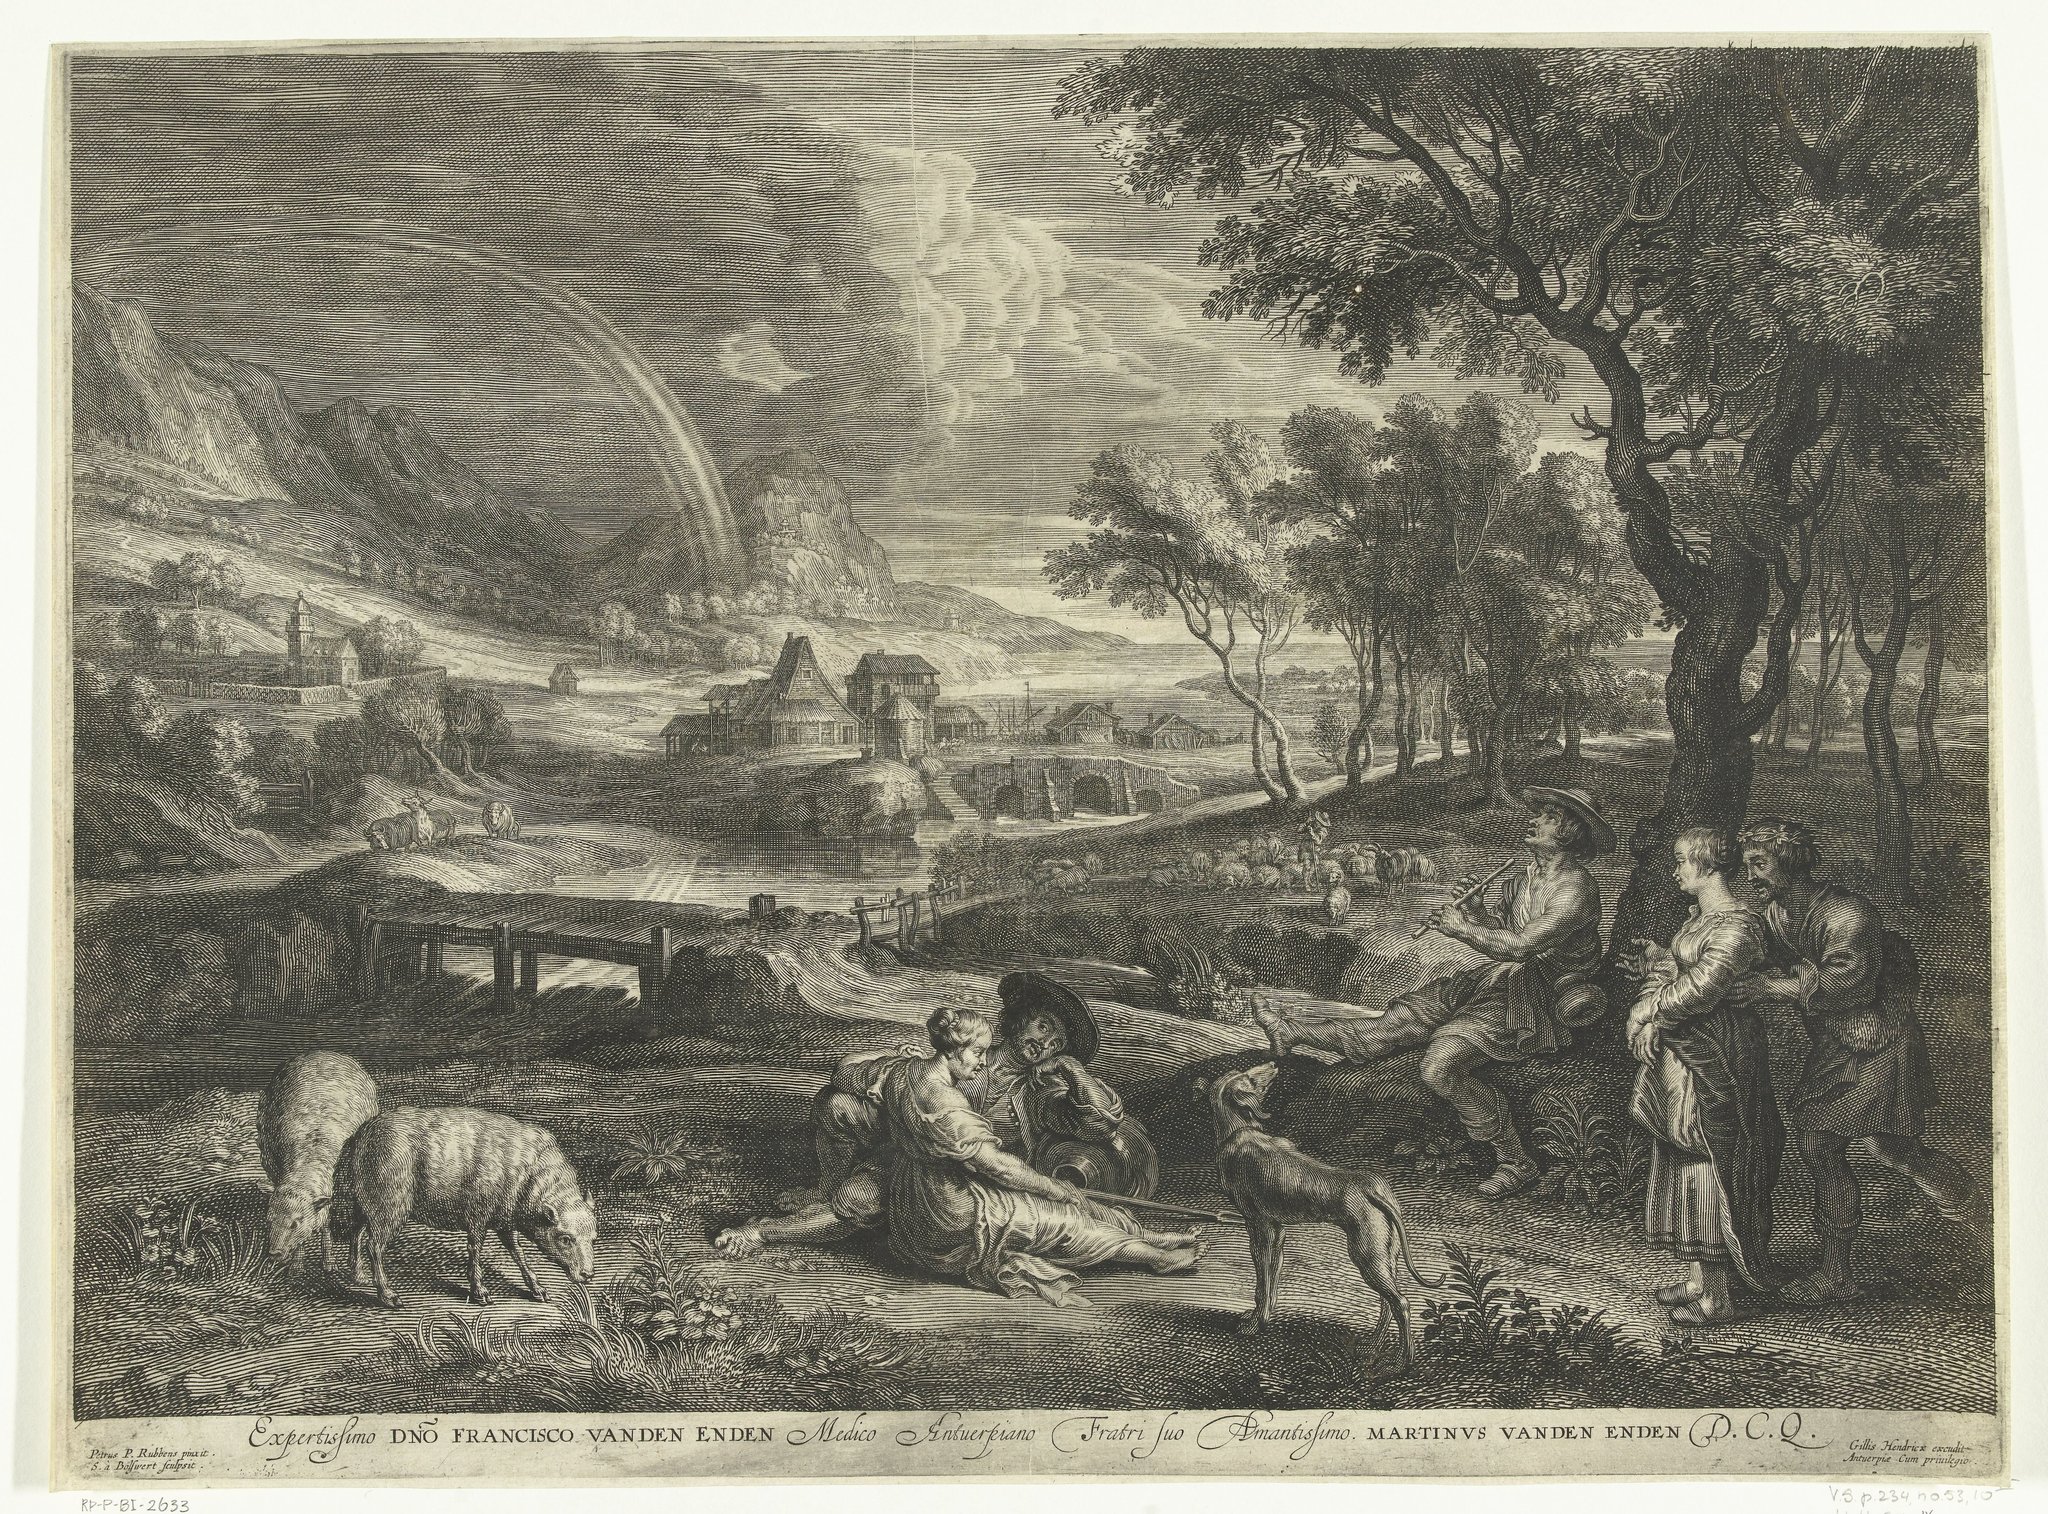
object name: print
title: Landschap met regenboog en herders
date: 1596-1659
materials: paper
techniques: engraving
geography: antwerp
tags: herding, herdsman, herdswoman, shepherd, shepherdess, cowherd, etc., pastorals, arcadian scenes, rainbow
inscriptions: collector's mark: Lugt 240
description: Prent naar schilderij van Peter Paul Rubens. Hollstein beschrijft een serie kleine landschappen onder de nrs. 305 t/m 325 maar deze prenten zijn niet als reeks vervaardigd.